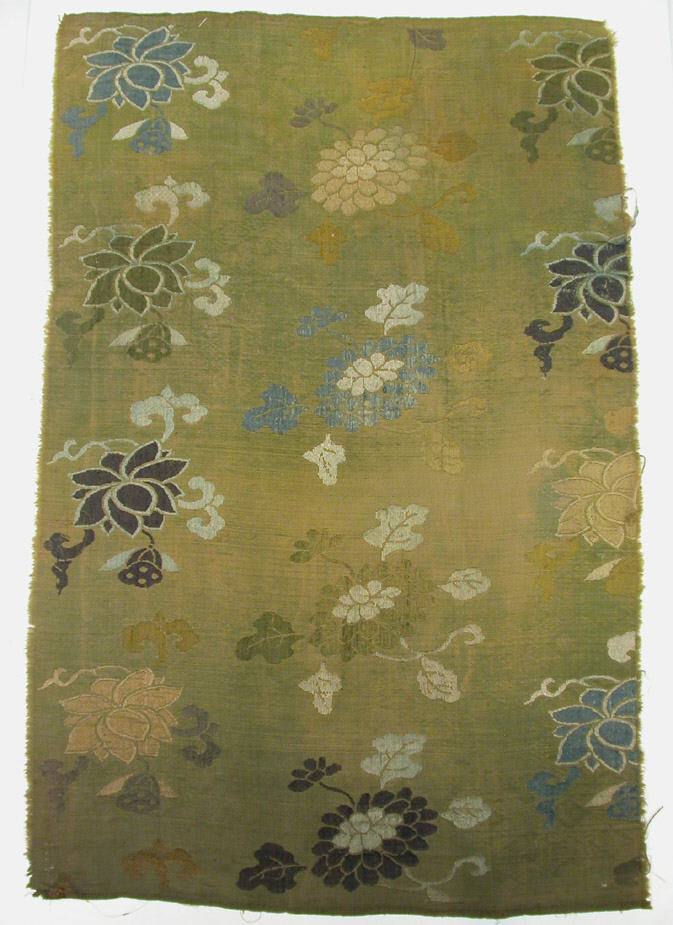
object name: piece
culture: chinese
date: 1701-1733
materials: metal thread, silk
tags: lotuses